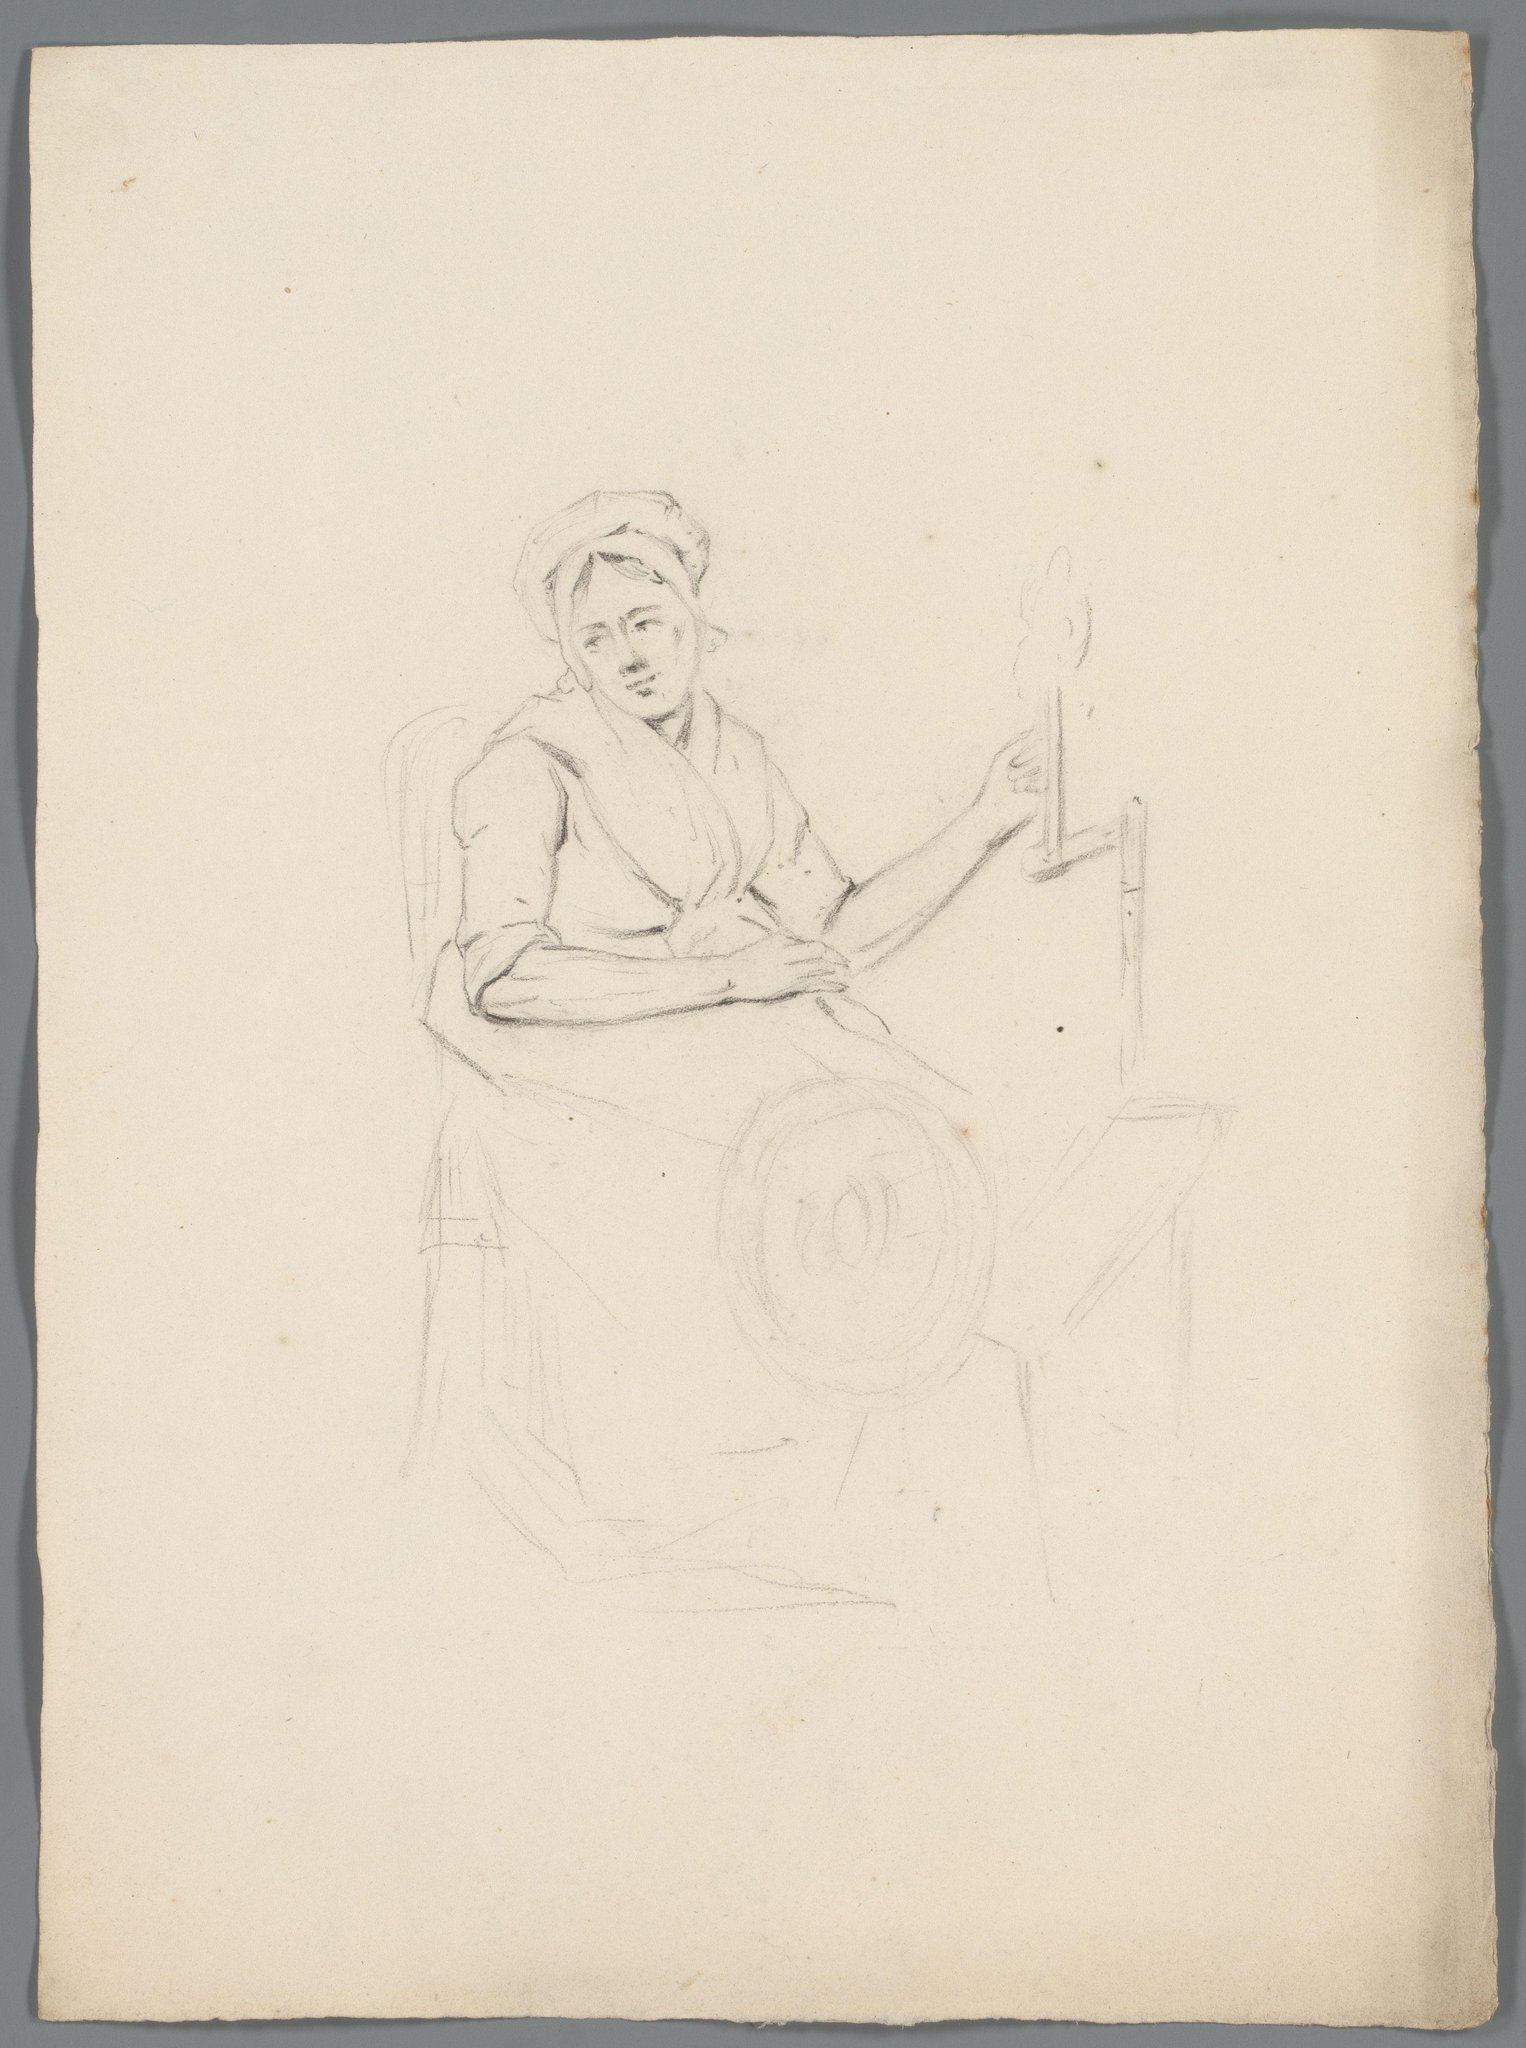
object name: drawing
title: Vrouw achter een spinnewiel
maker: Anonymous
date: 1820-1830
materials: chalk, paper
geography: the hague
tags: adult woman, spinning-wheel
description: Tekeningen waarschijnlijk ontstaan bij het Haagse kunstgenootschap ‘Tot Nut der Tekenkunst’, waar twee keer per week tekenavonden werden georganiseerd met geklede modellen.